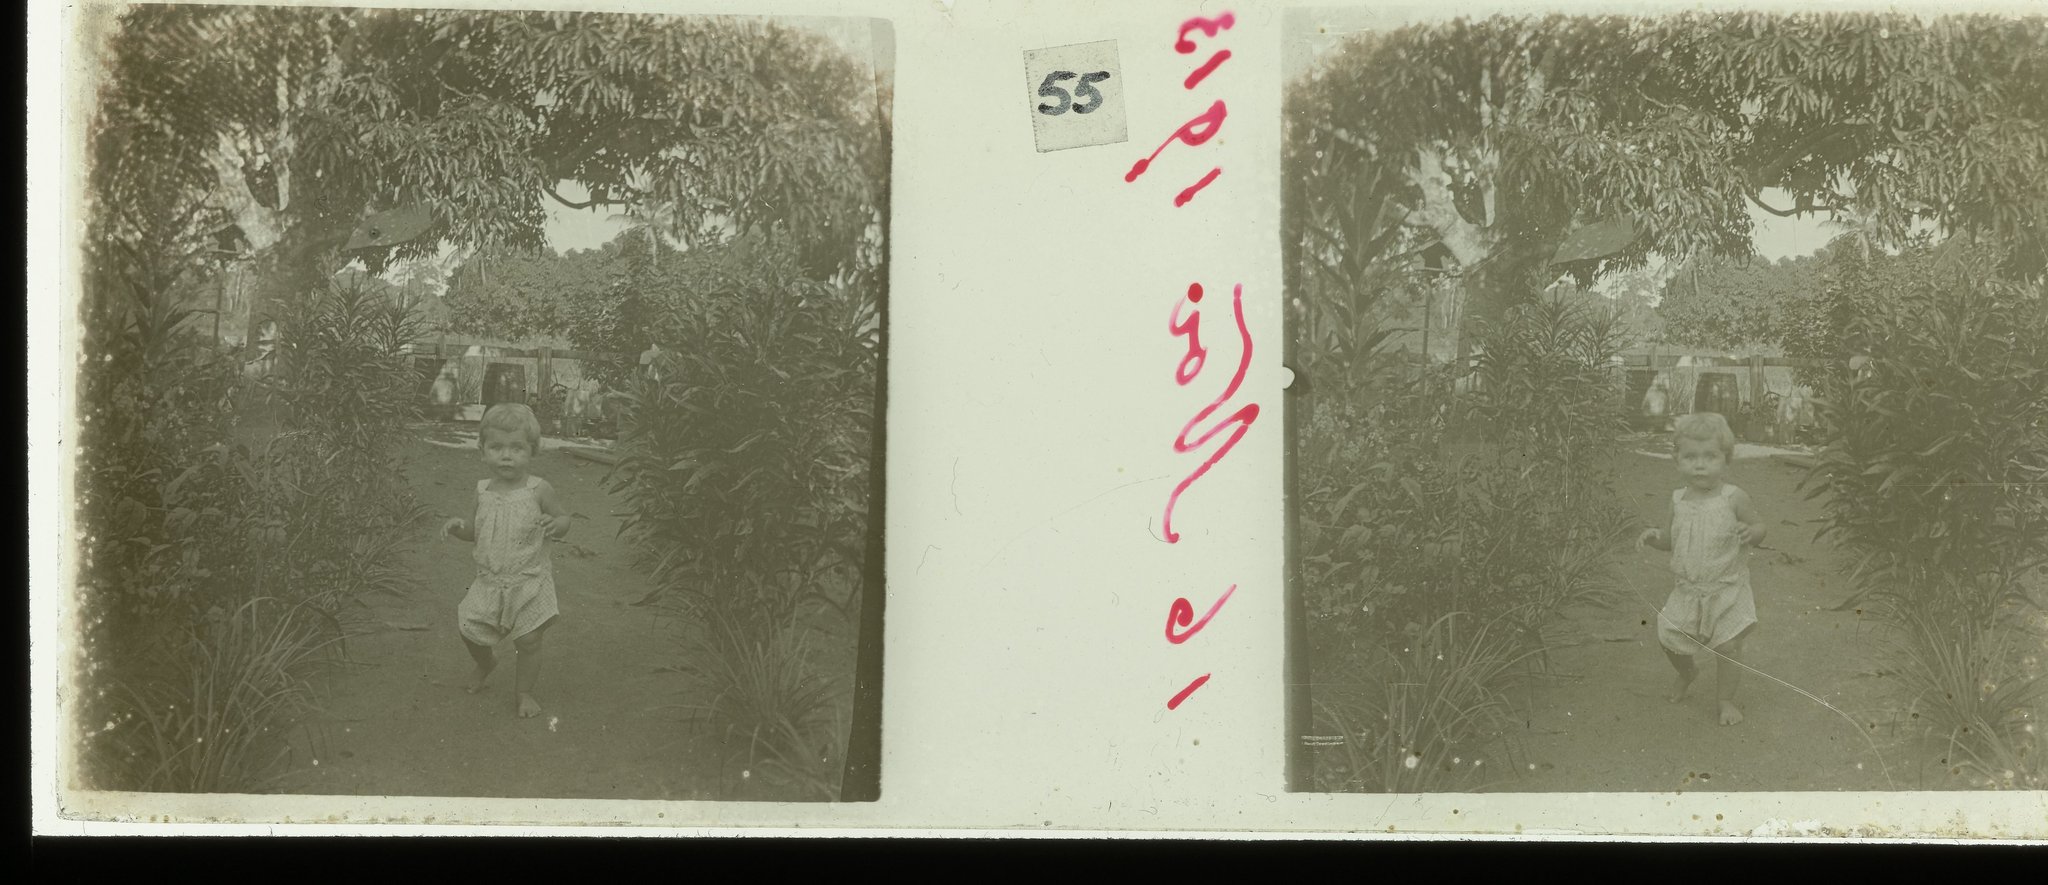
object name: stereograph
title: Gerard Brouwers op Plantage Accaribo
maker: theodoor brouwers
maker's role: amateurfotograaf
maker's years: 1874-1932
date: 1913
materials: glass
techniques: photography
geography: suriname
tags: amsterdam, theodoor brouwers, plantation, suriname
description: In de periode 1911-1932 woonde op plantage Accaribo in Suriname de familie Brouwers van wie de foto's afkomstig zijn. Rond 1910 vond Theodoor Brouwers werk op plantage Accaribo. In 1929 werd hij eigenaar van de plantage. Op Accaribo werden in zijn tijd bananen geproduceerd en wat koffie.